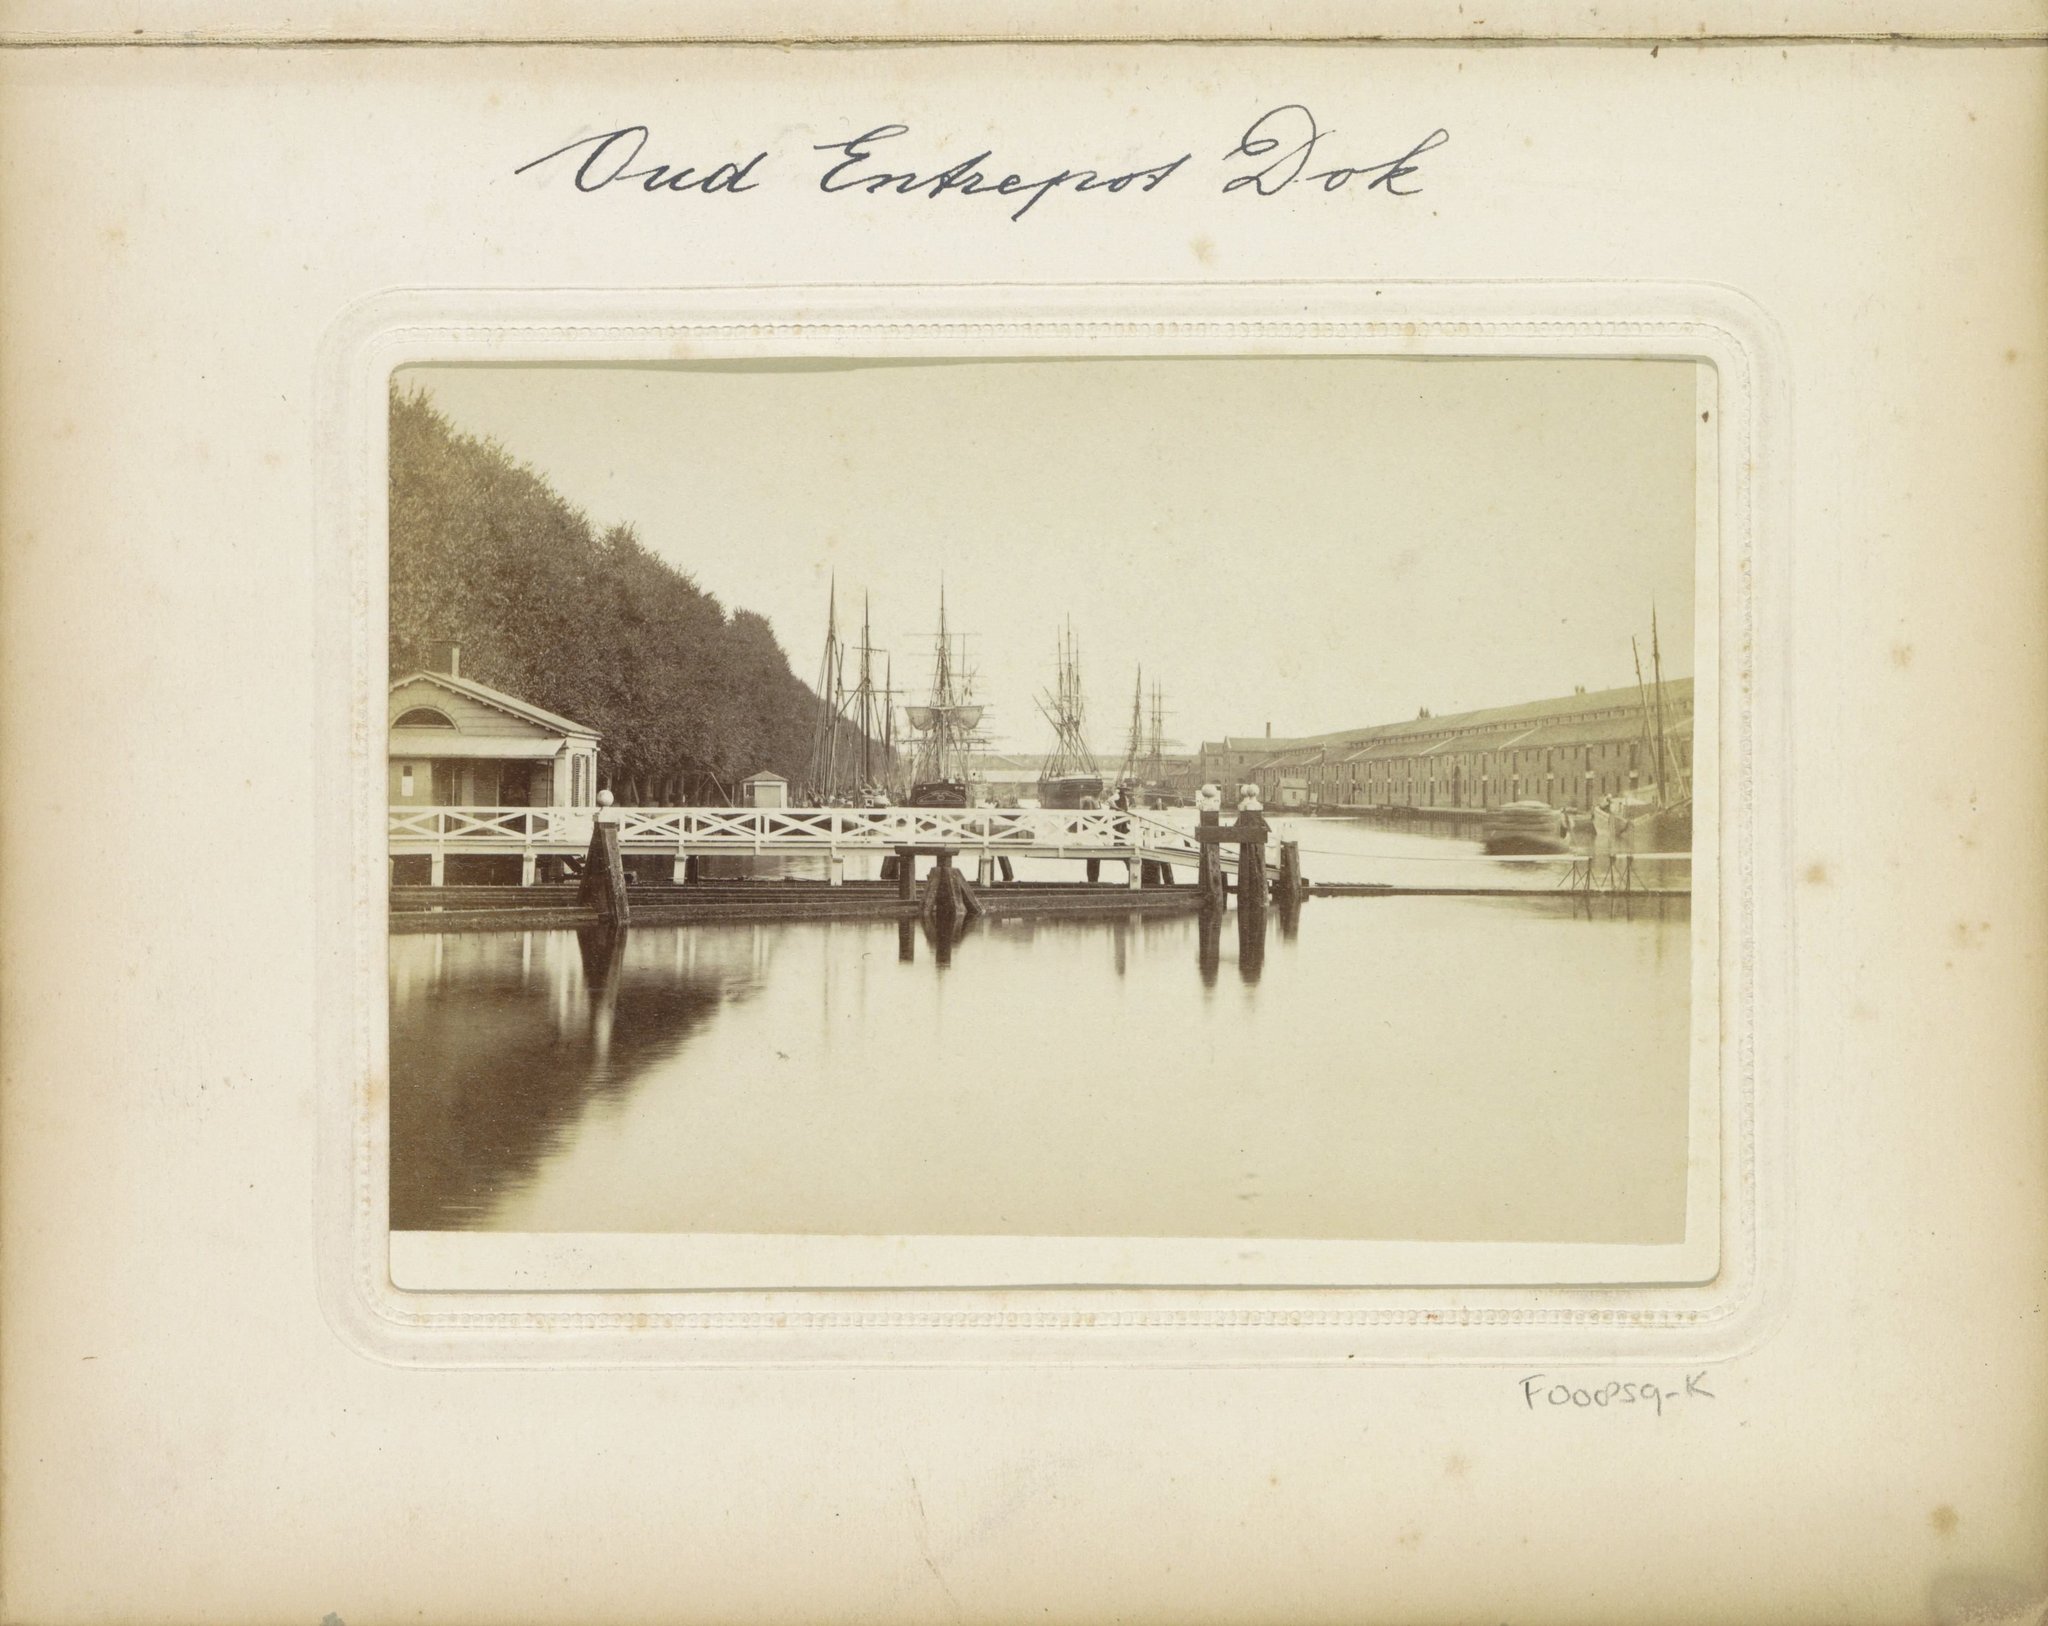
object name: photograph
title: Schepen in het oude Entrepotdok van Amsterdam, gezien richting oost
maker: Anonymous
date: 1850-1875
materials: cardboard, paper, photographic support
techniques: albumen print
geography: amsterdam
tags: warehouse (~ harbour), sailing-ship, sailing-boat, prospect of city, town panorama, silhouette of city, amsterdam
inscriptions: inscription: ‘Oud-Entrepot Dok. Amsterdam’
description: Onderdeel van Fotoalbum met opnames van straten, pleinen en grachten in Amsterdam.